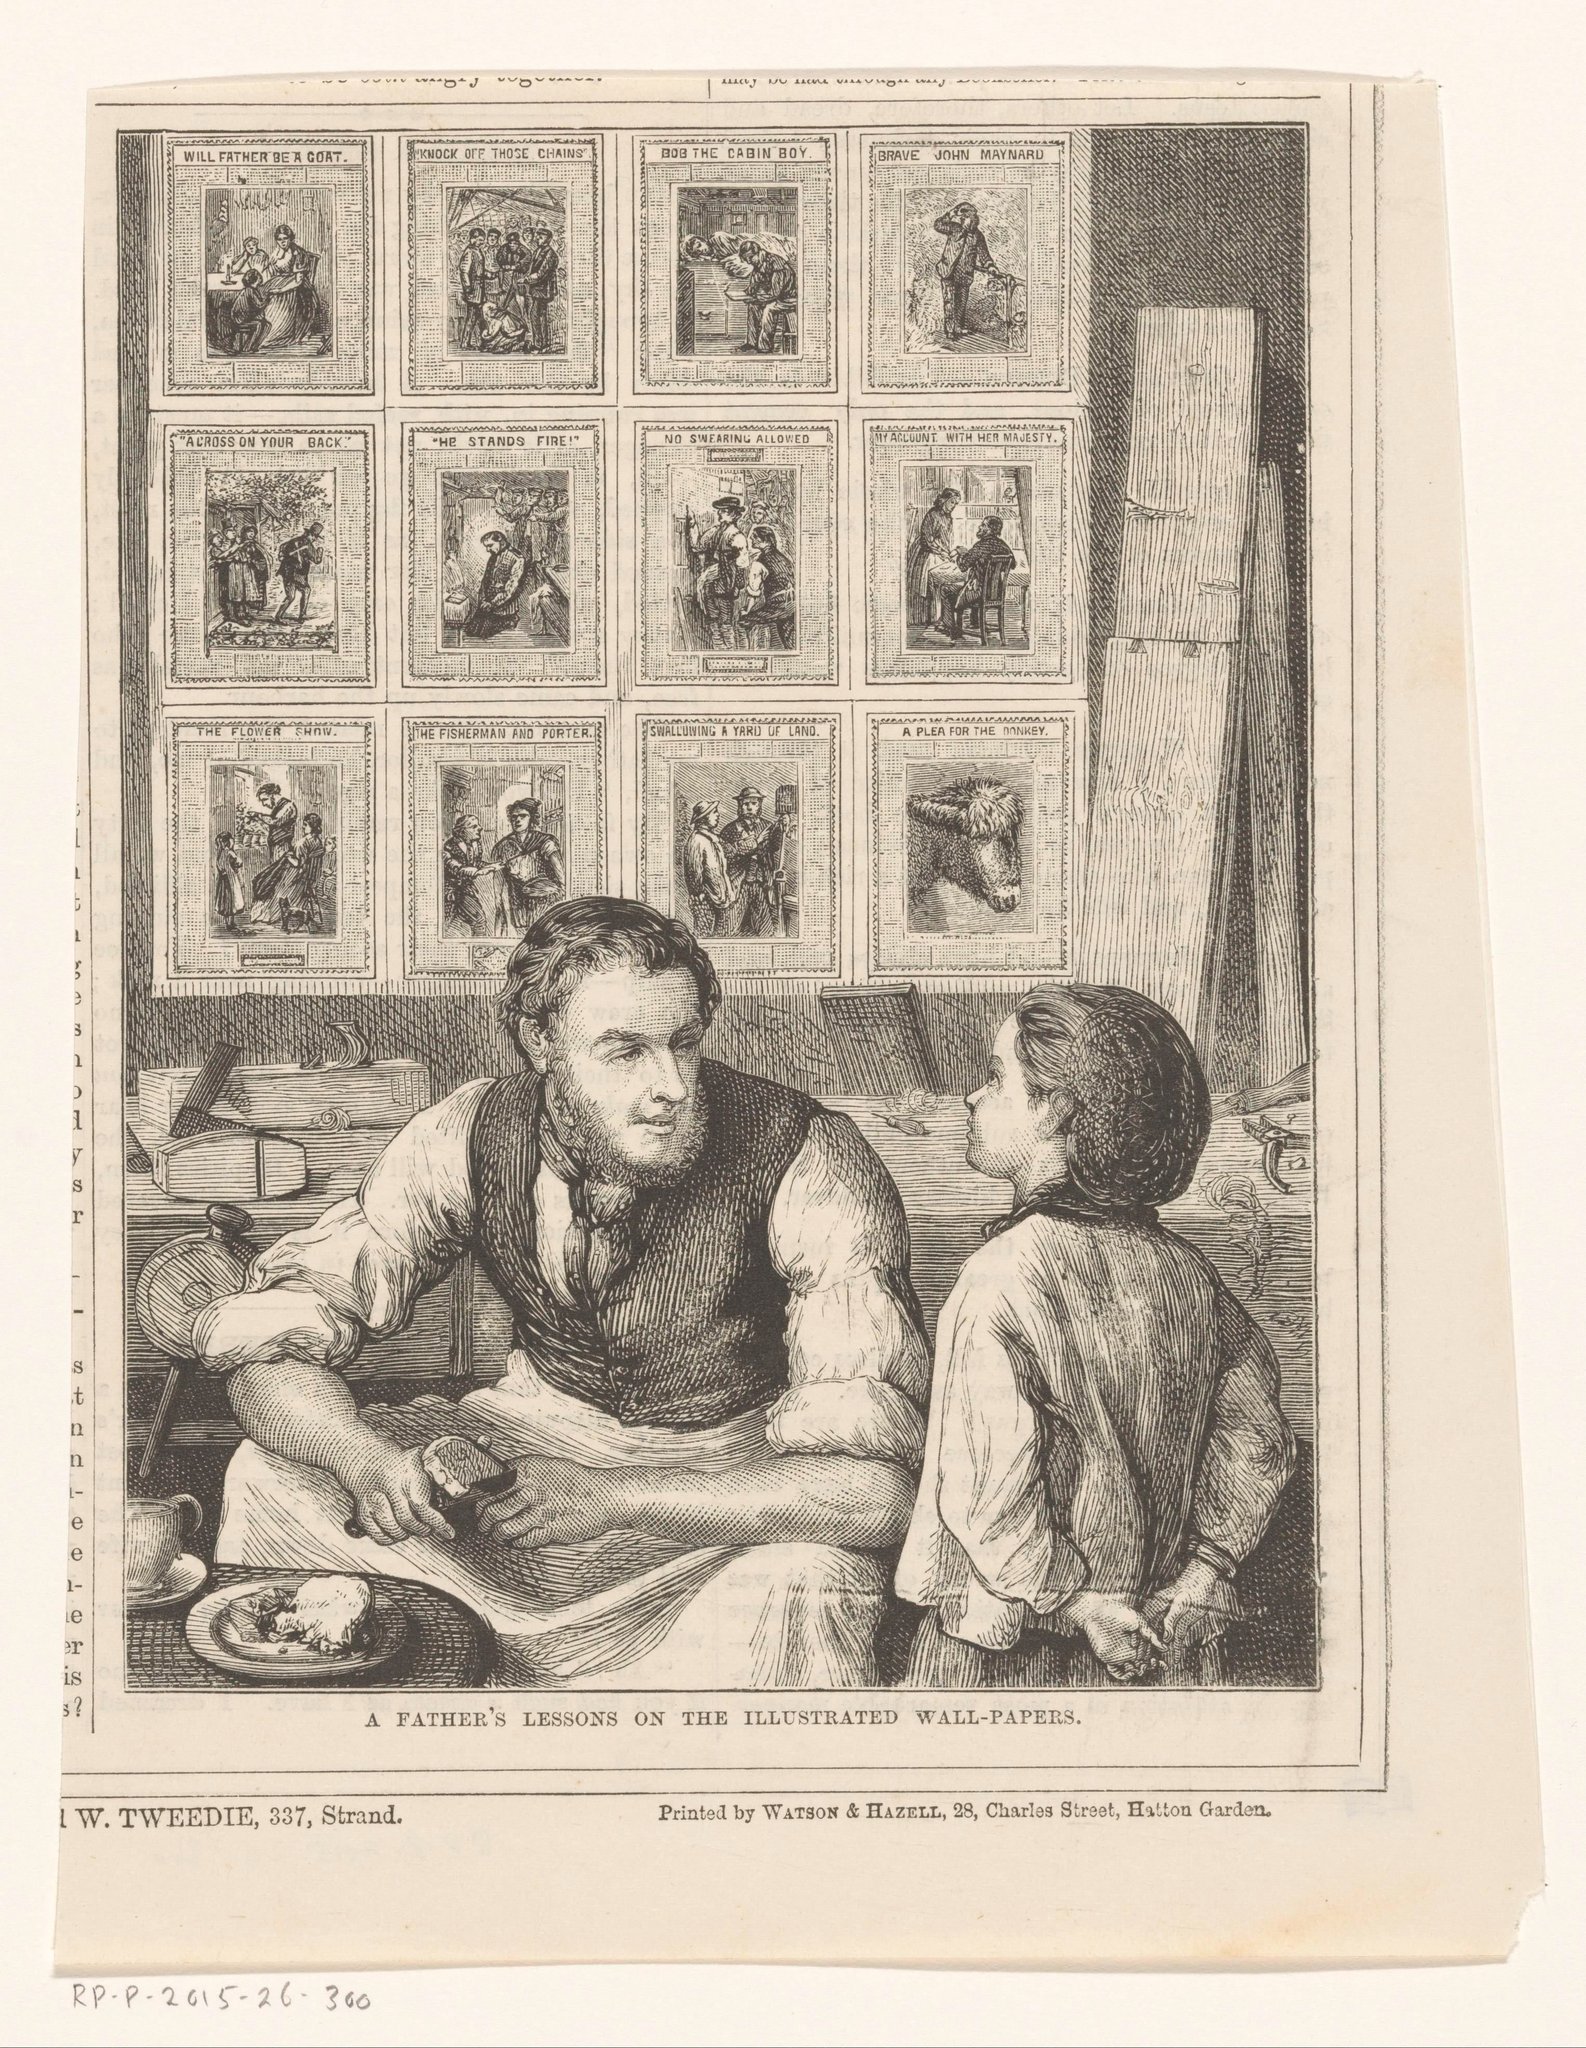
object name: print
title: A father's lessons on the illustrated wall-papers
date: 1867-1884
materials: paper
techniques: letterpress printing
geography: london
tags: carpenter, good and bad behaviour, moral qualities, father and son(s) (family group)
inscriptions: collector's mark: Lugt 2228, collector's mark: Lugt 4780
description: Een timmerman in zijn werkplaats spreekt zijn zoon toe aan de hand van prenten die achter hem hangen. Deze "illustrated wall-papers" werden per set verkocht en hadden vaak een moraliserende boodschap.